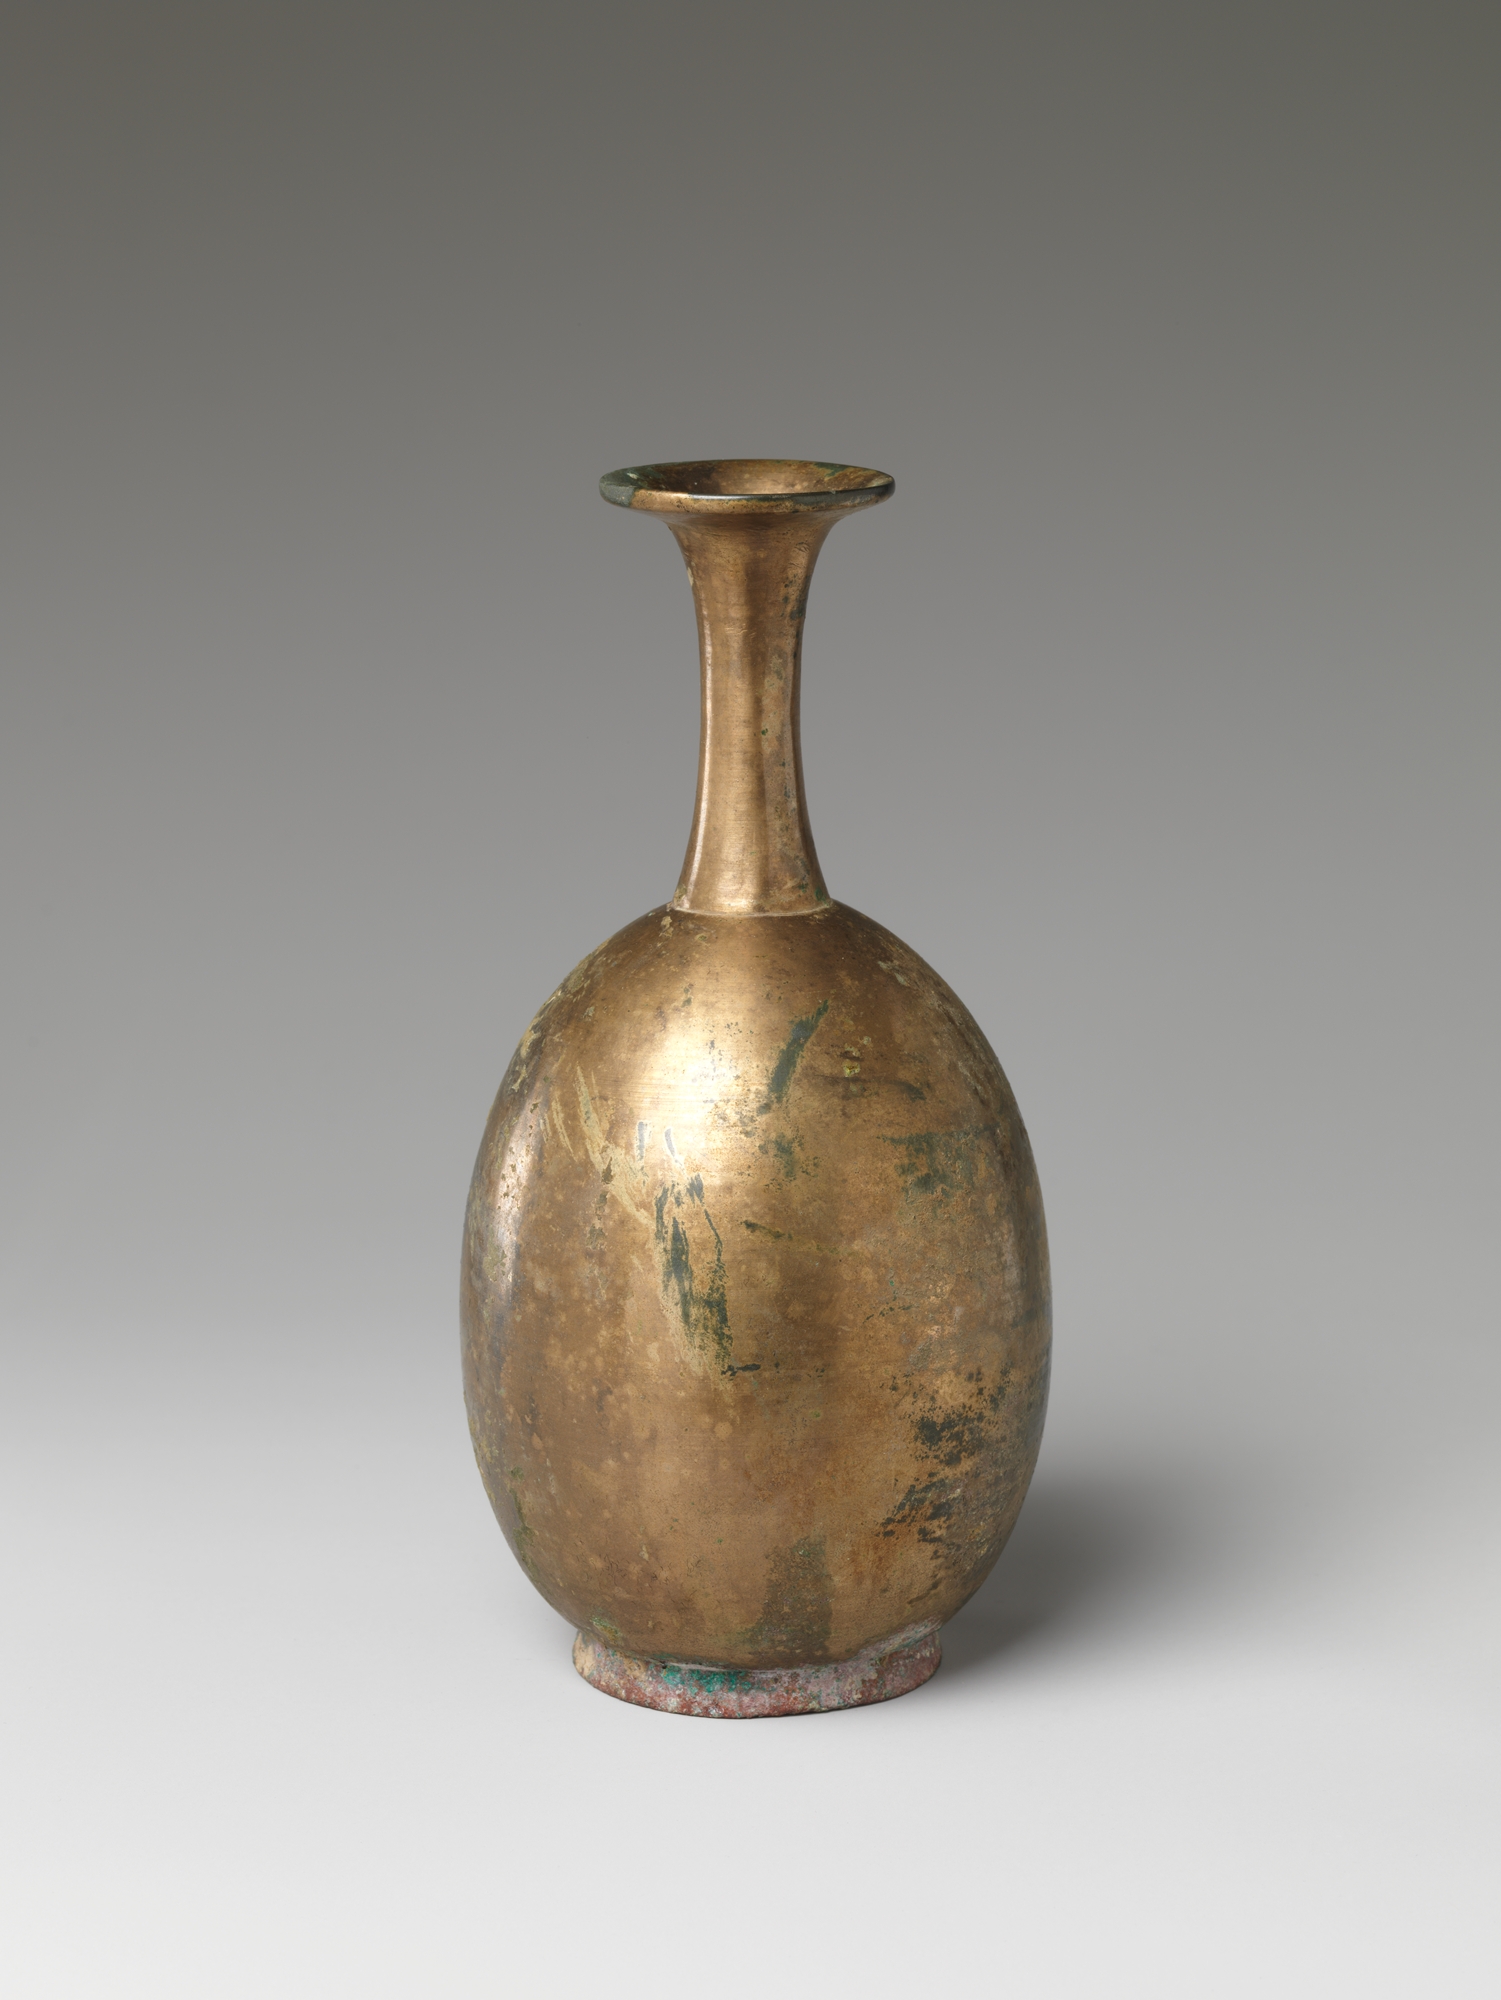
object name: bottle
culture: chinese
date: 550-577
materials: bronze